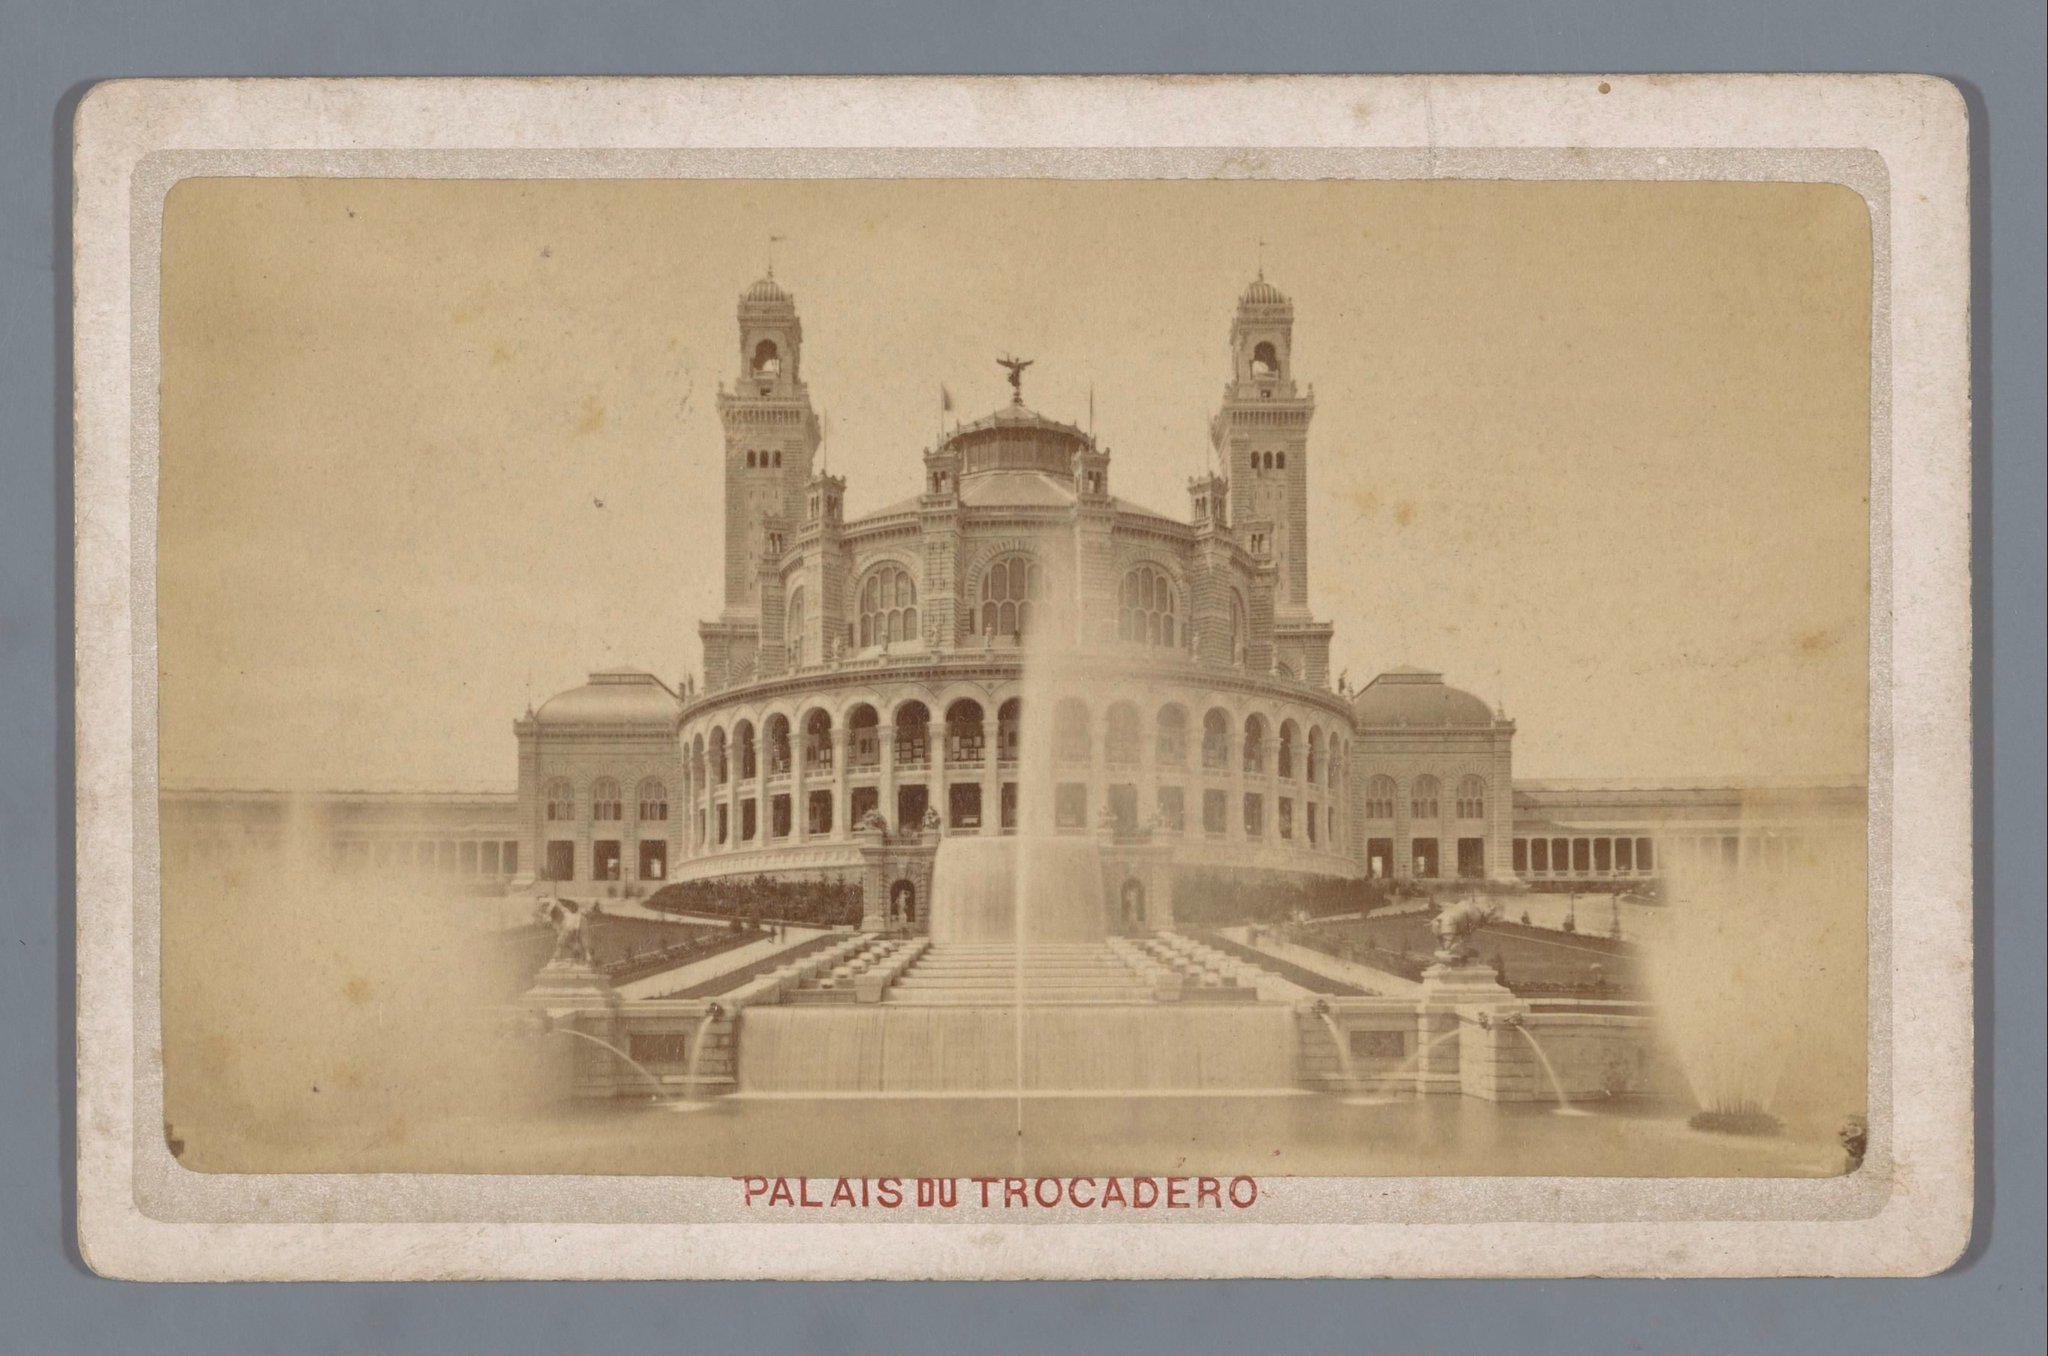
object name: photograph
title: Palais du Trocadero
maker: Anonymous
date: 1870-1900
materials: cardboard, paper, photographic support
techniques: albumen print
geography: paris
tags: palace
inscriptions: : ‘Palais du Trocadero’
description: Het paleis Trocadero, ooit gelegen aan het plein Trocadero met zijn vele fonteinen in Parijs. Het paleis is in 1867 gebouwd en rond 1917 weer afgebroken.